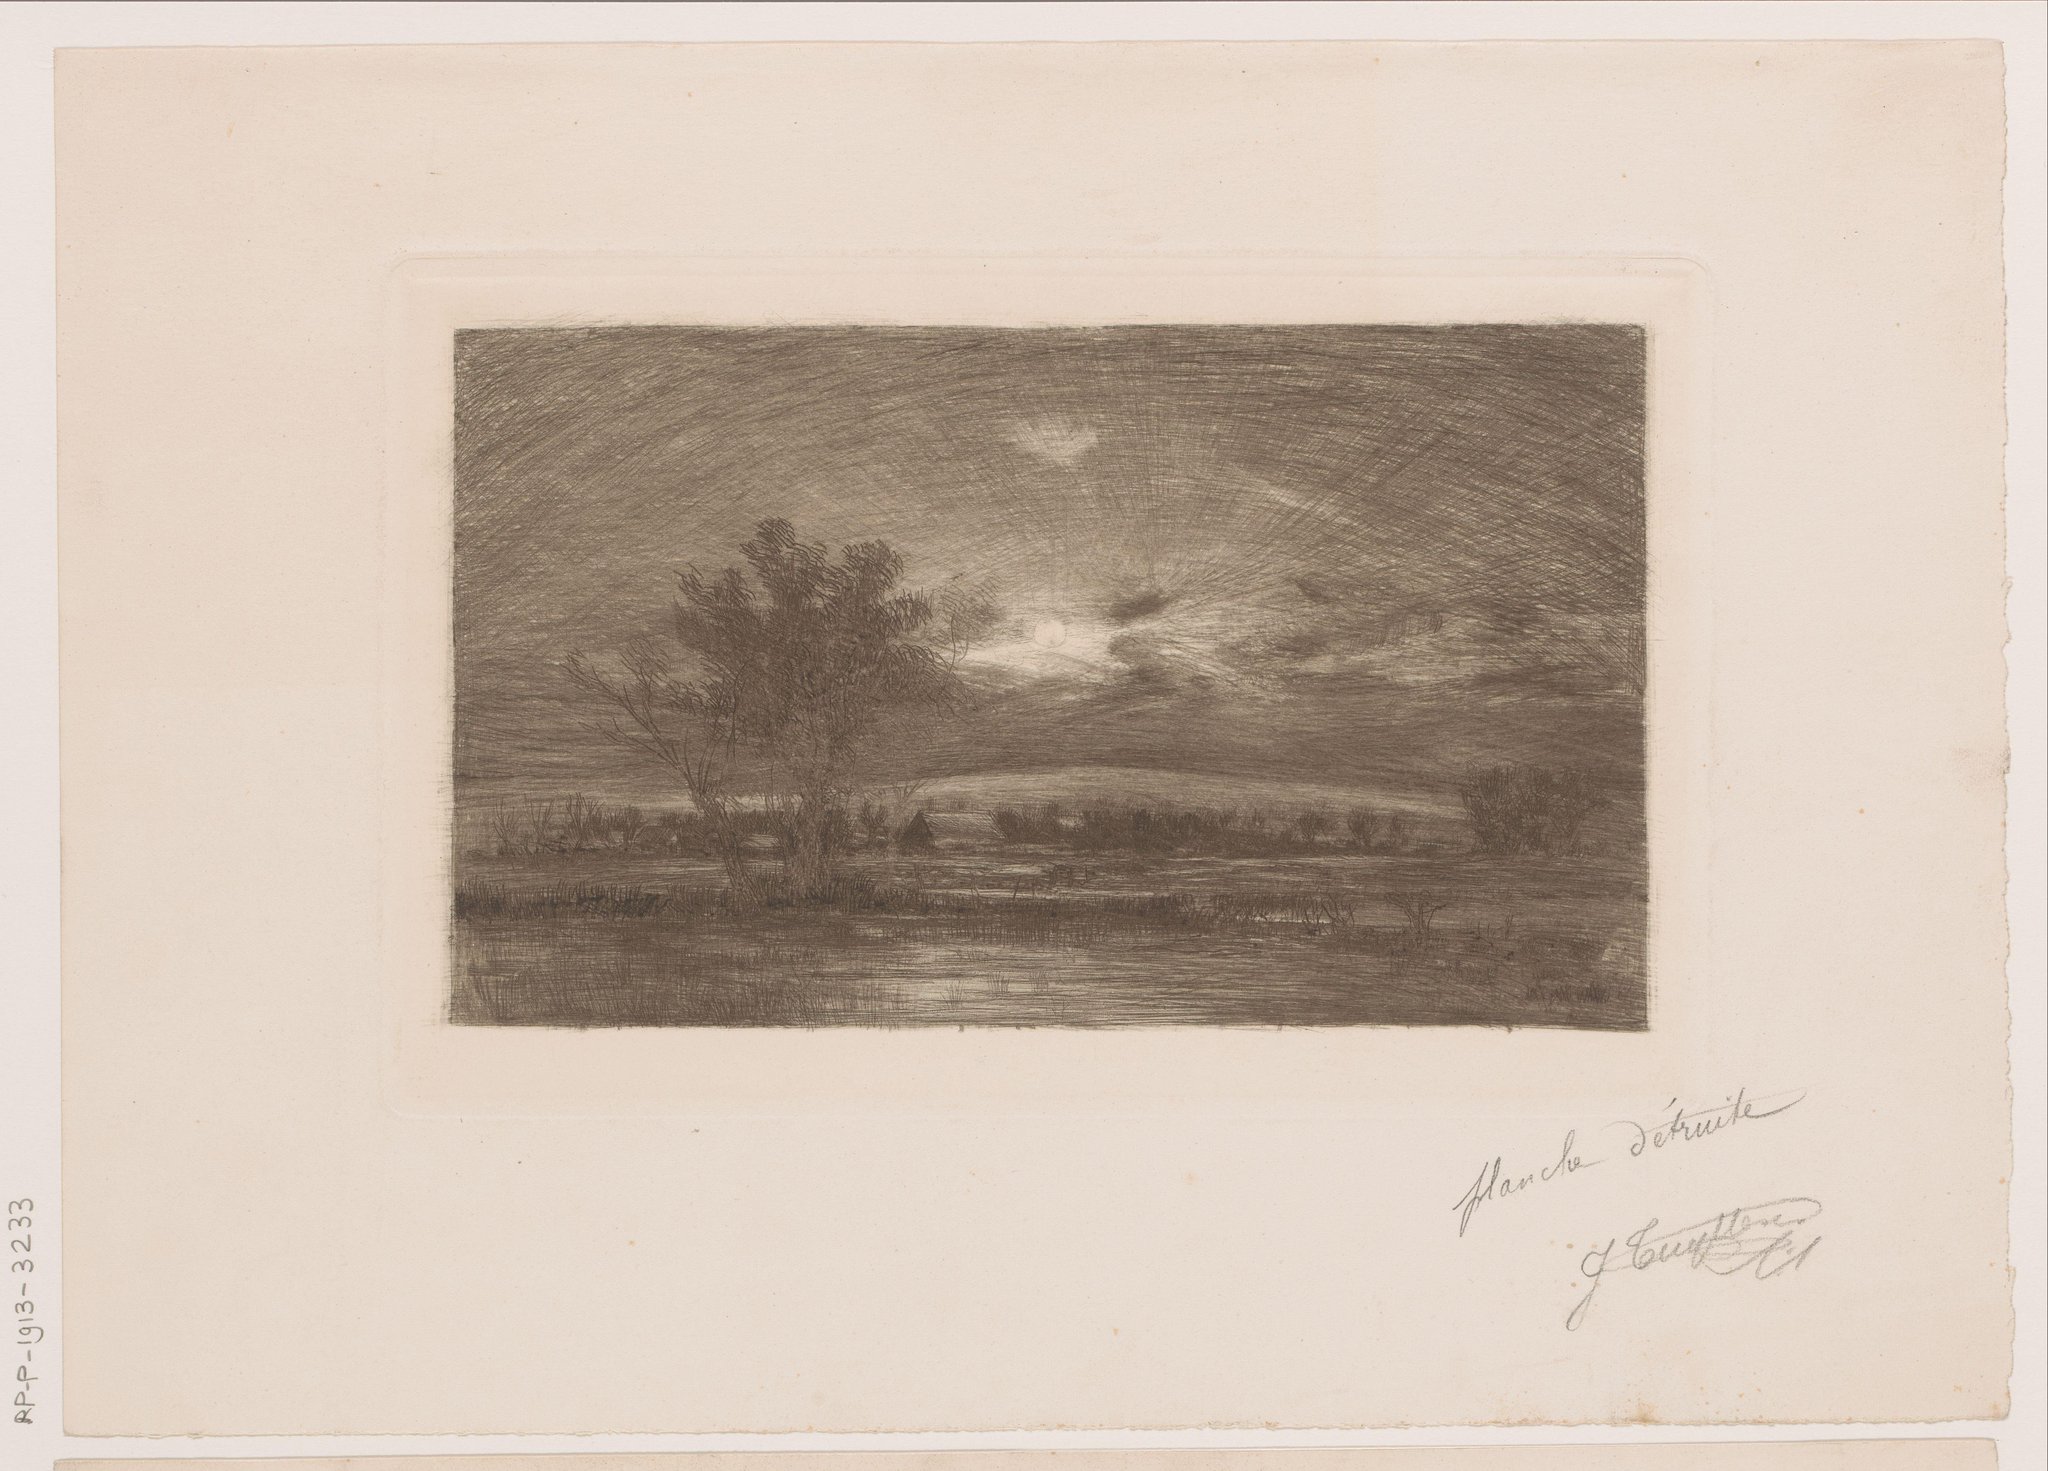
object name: print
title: Winterlandschap bij maanlicht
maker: jerôme tuyttens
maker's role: painter, print maker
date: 1850-1900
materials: paper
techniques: drypoint, etching, intaglio, roulette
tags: landscapes, moonlight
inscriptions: annotation: ‘planche détruite’, collector's mark: Lugt 2228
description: Sterfdatum van de prentmaker is onbekend. Daarom is voor de bepaling van de rechten van dit object gebruik gemaakt van de verwervingsdatum Rijksmuseum Amsterdam.